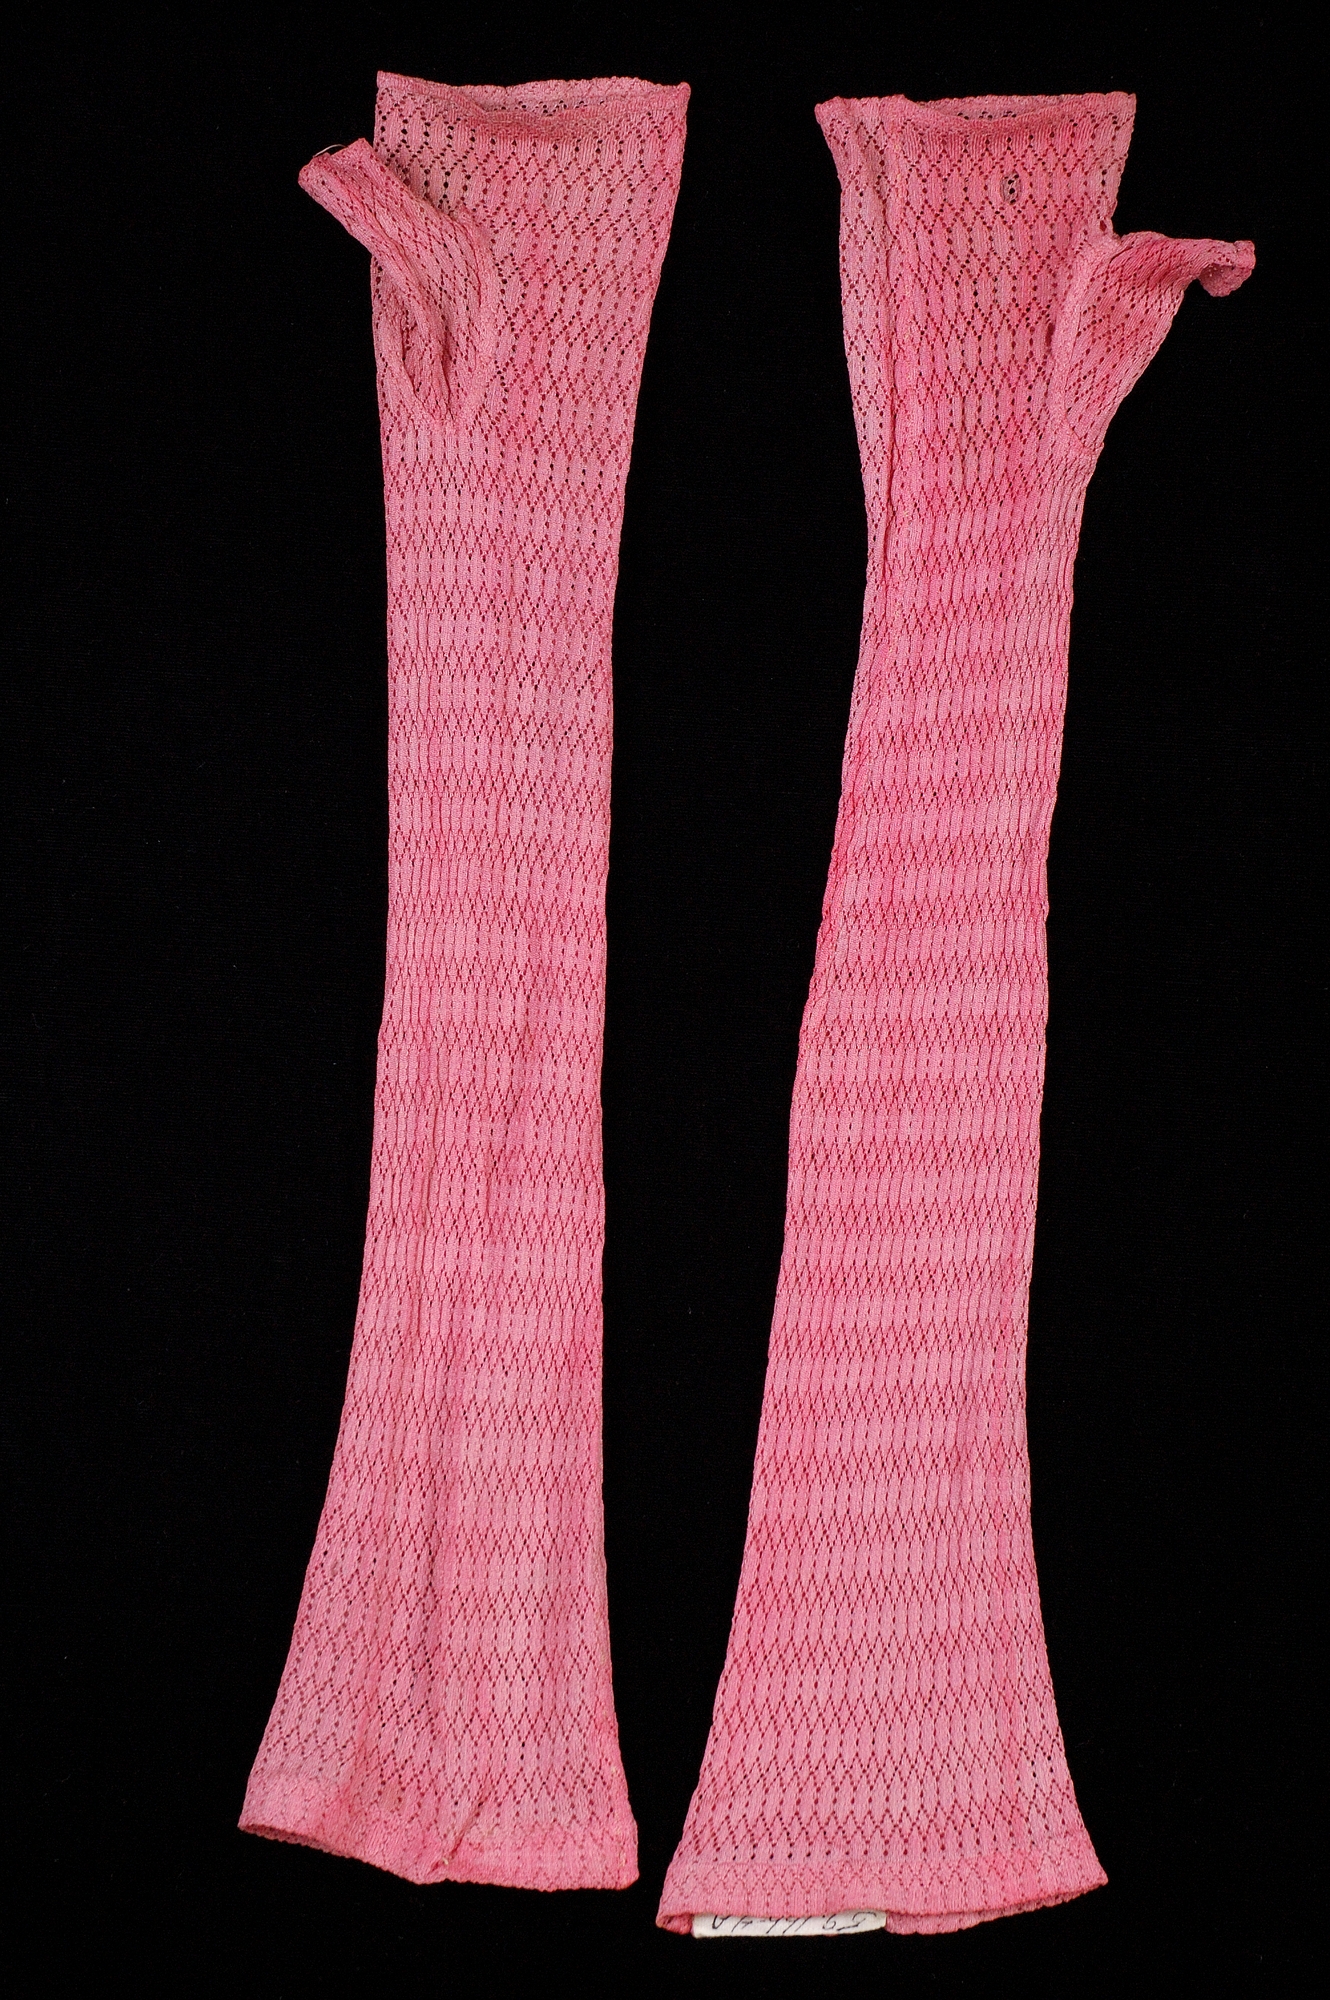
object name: evening mitt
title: Evening mitts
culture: american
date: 1851-1875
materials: silk